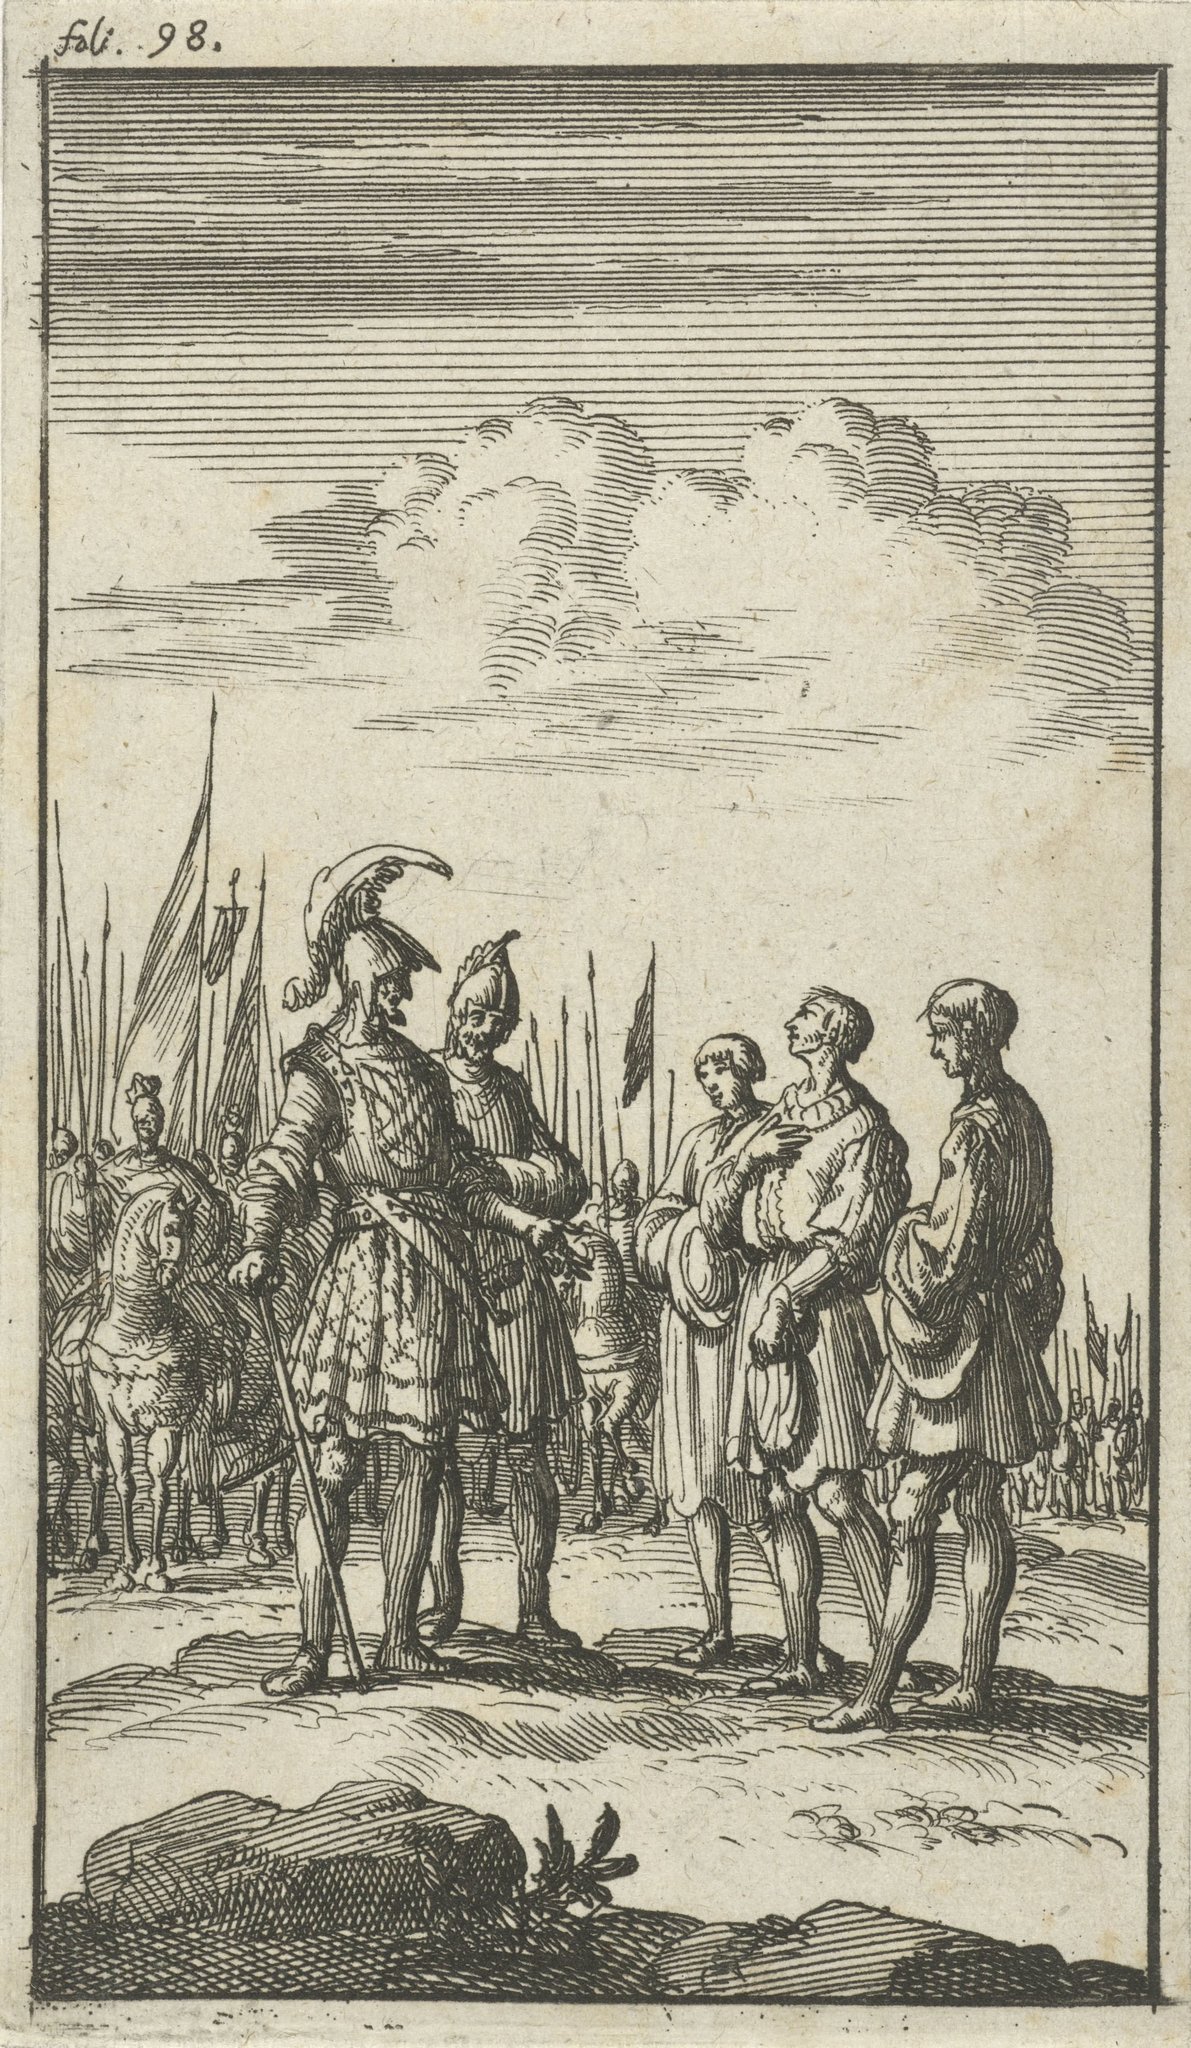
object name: book illustration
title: Drie ongewapende mannen in gesprek met twee legerbevelhebbers, op de achtergrond soldaten te paard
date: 1685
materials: paper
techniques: etching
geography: amsterdam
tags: commander-in-chief, general, marshal, land forces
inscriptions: collector's mark: Lugt 2228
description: Illustratie uit: Bunyan, John. Den heyligen oorlogh. Amsterdam: Johannes Boekholt, 1685.